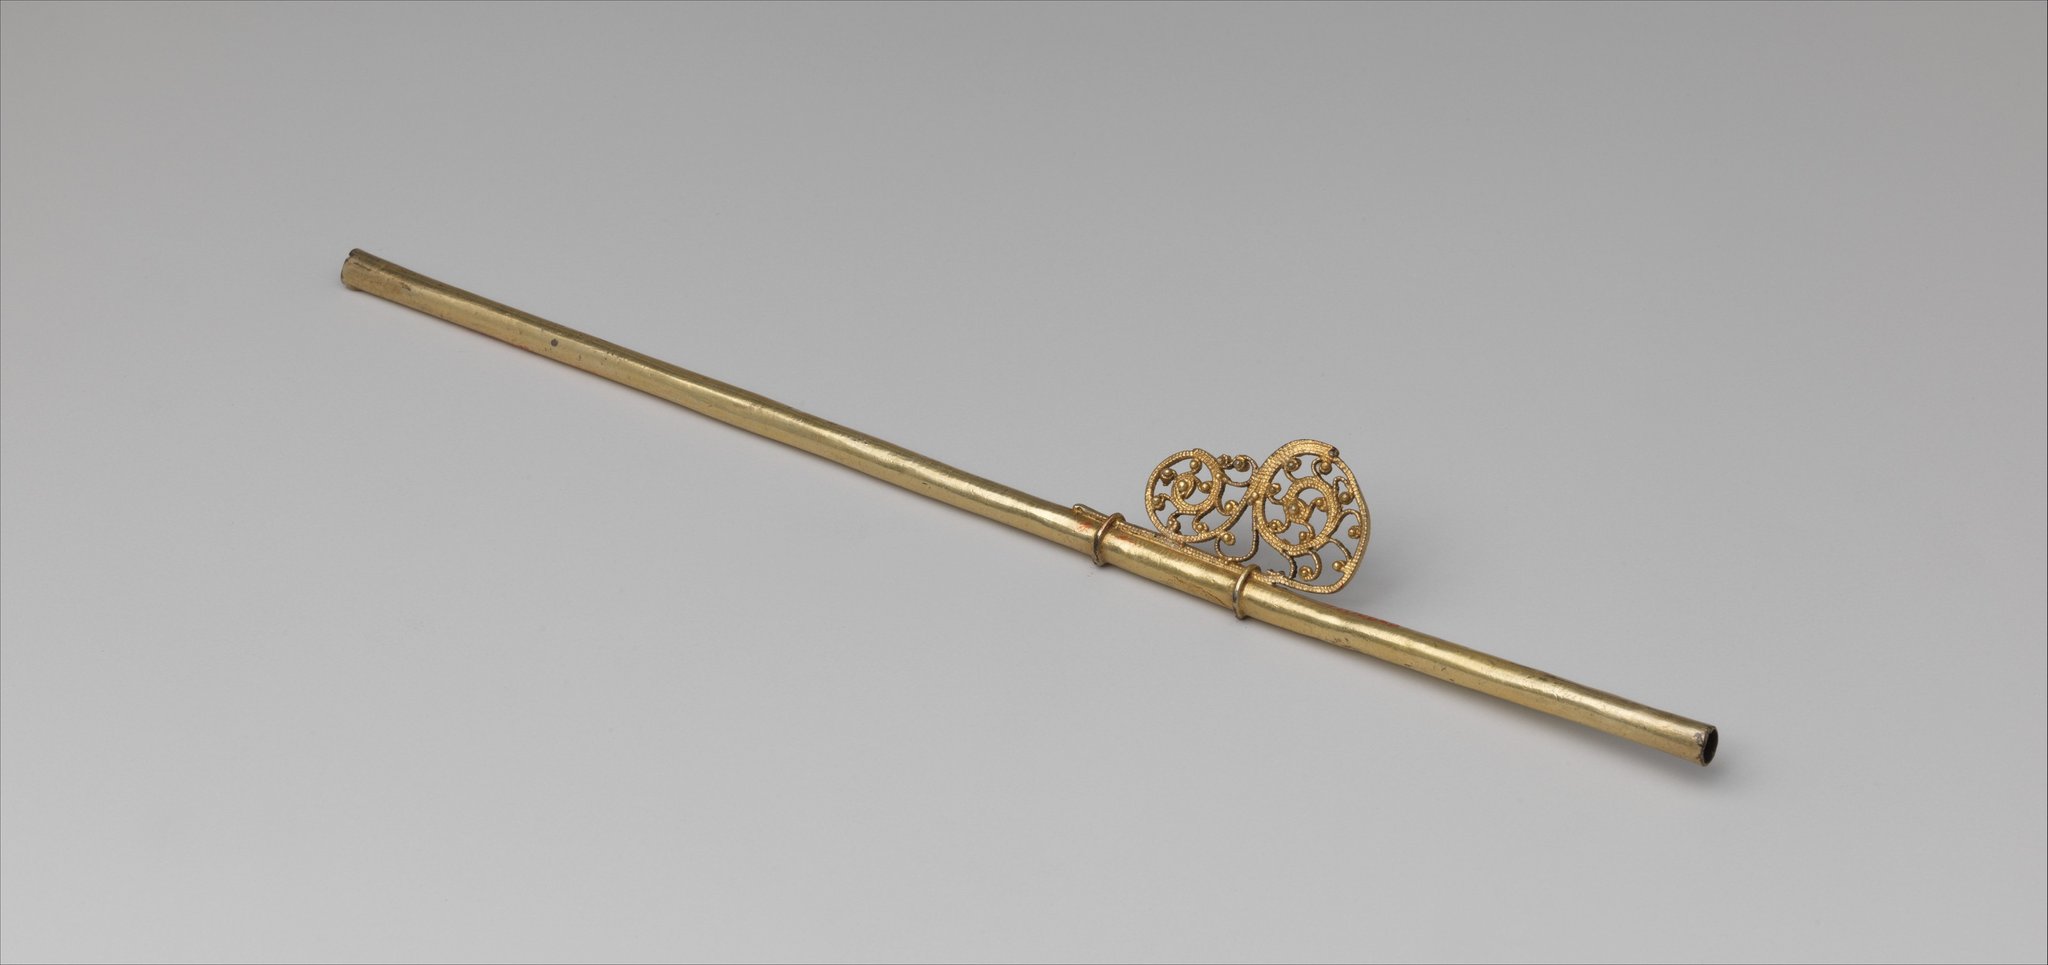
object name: straw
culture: german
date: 1230-1250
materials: gilt, niello, silver